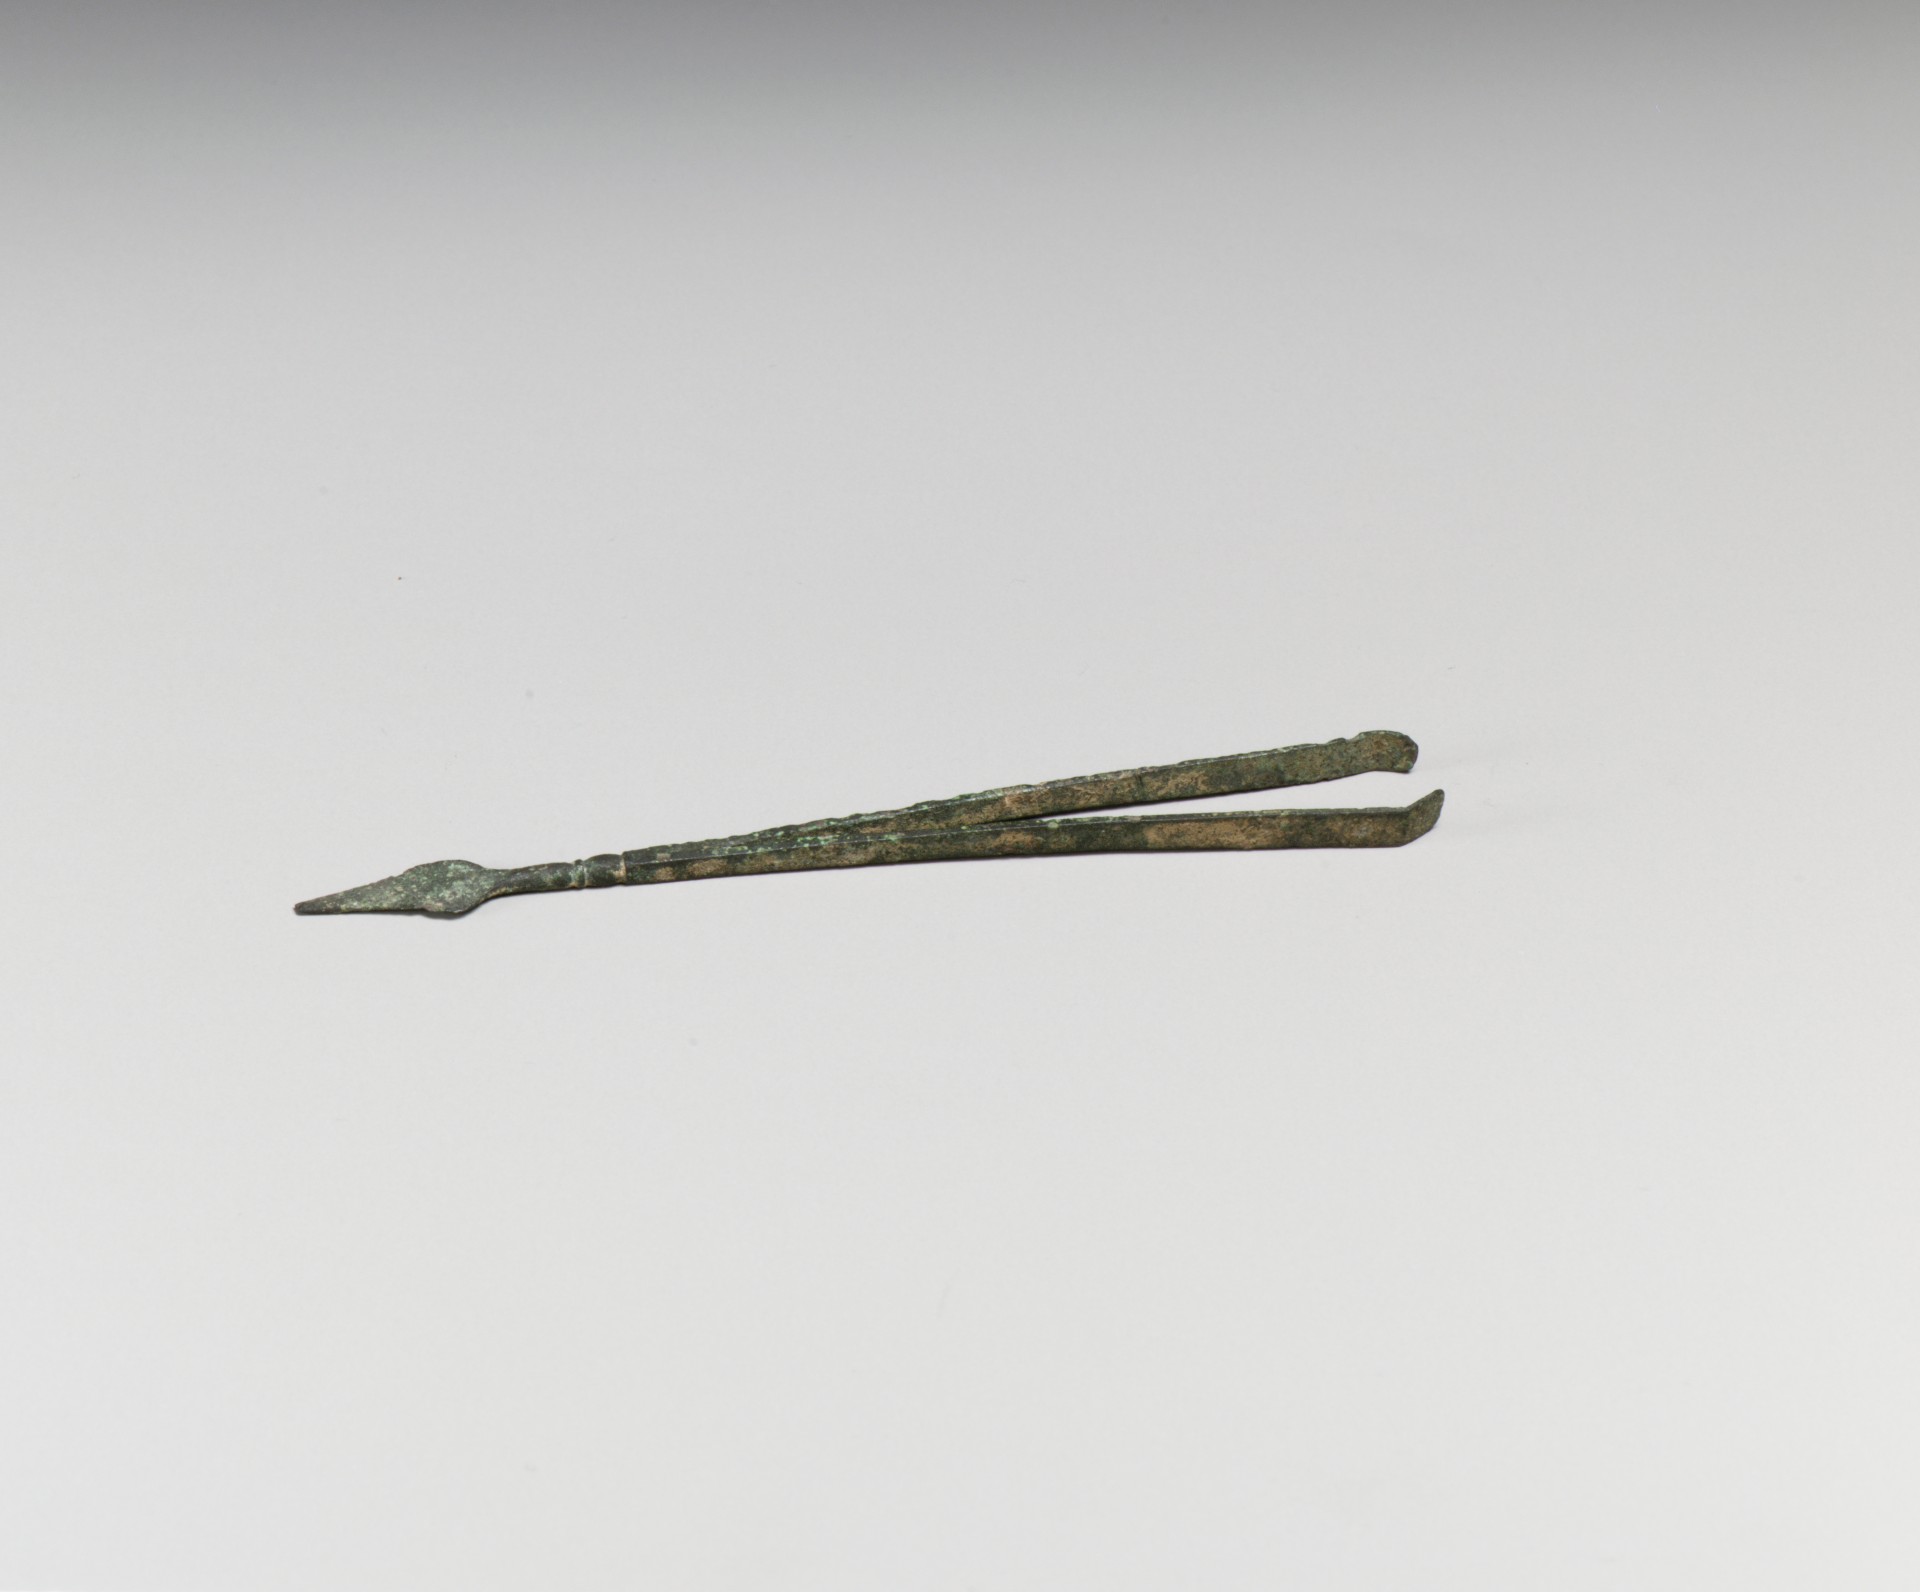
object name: tweezer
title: Tweezers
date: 7000 BCE-330 CE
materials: bronze